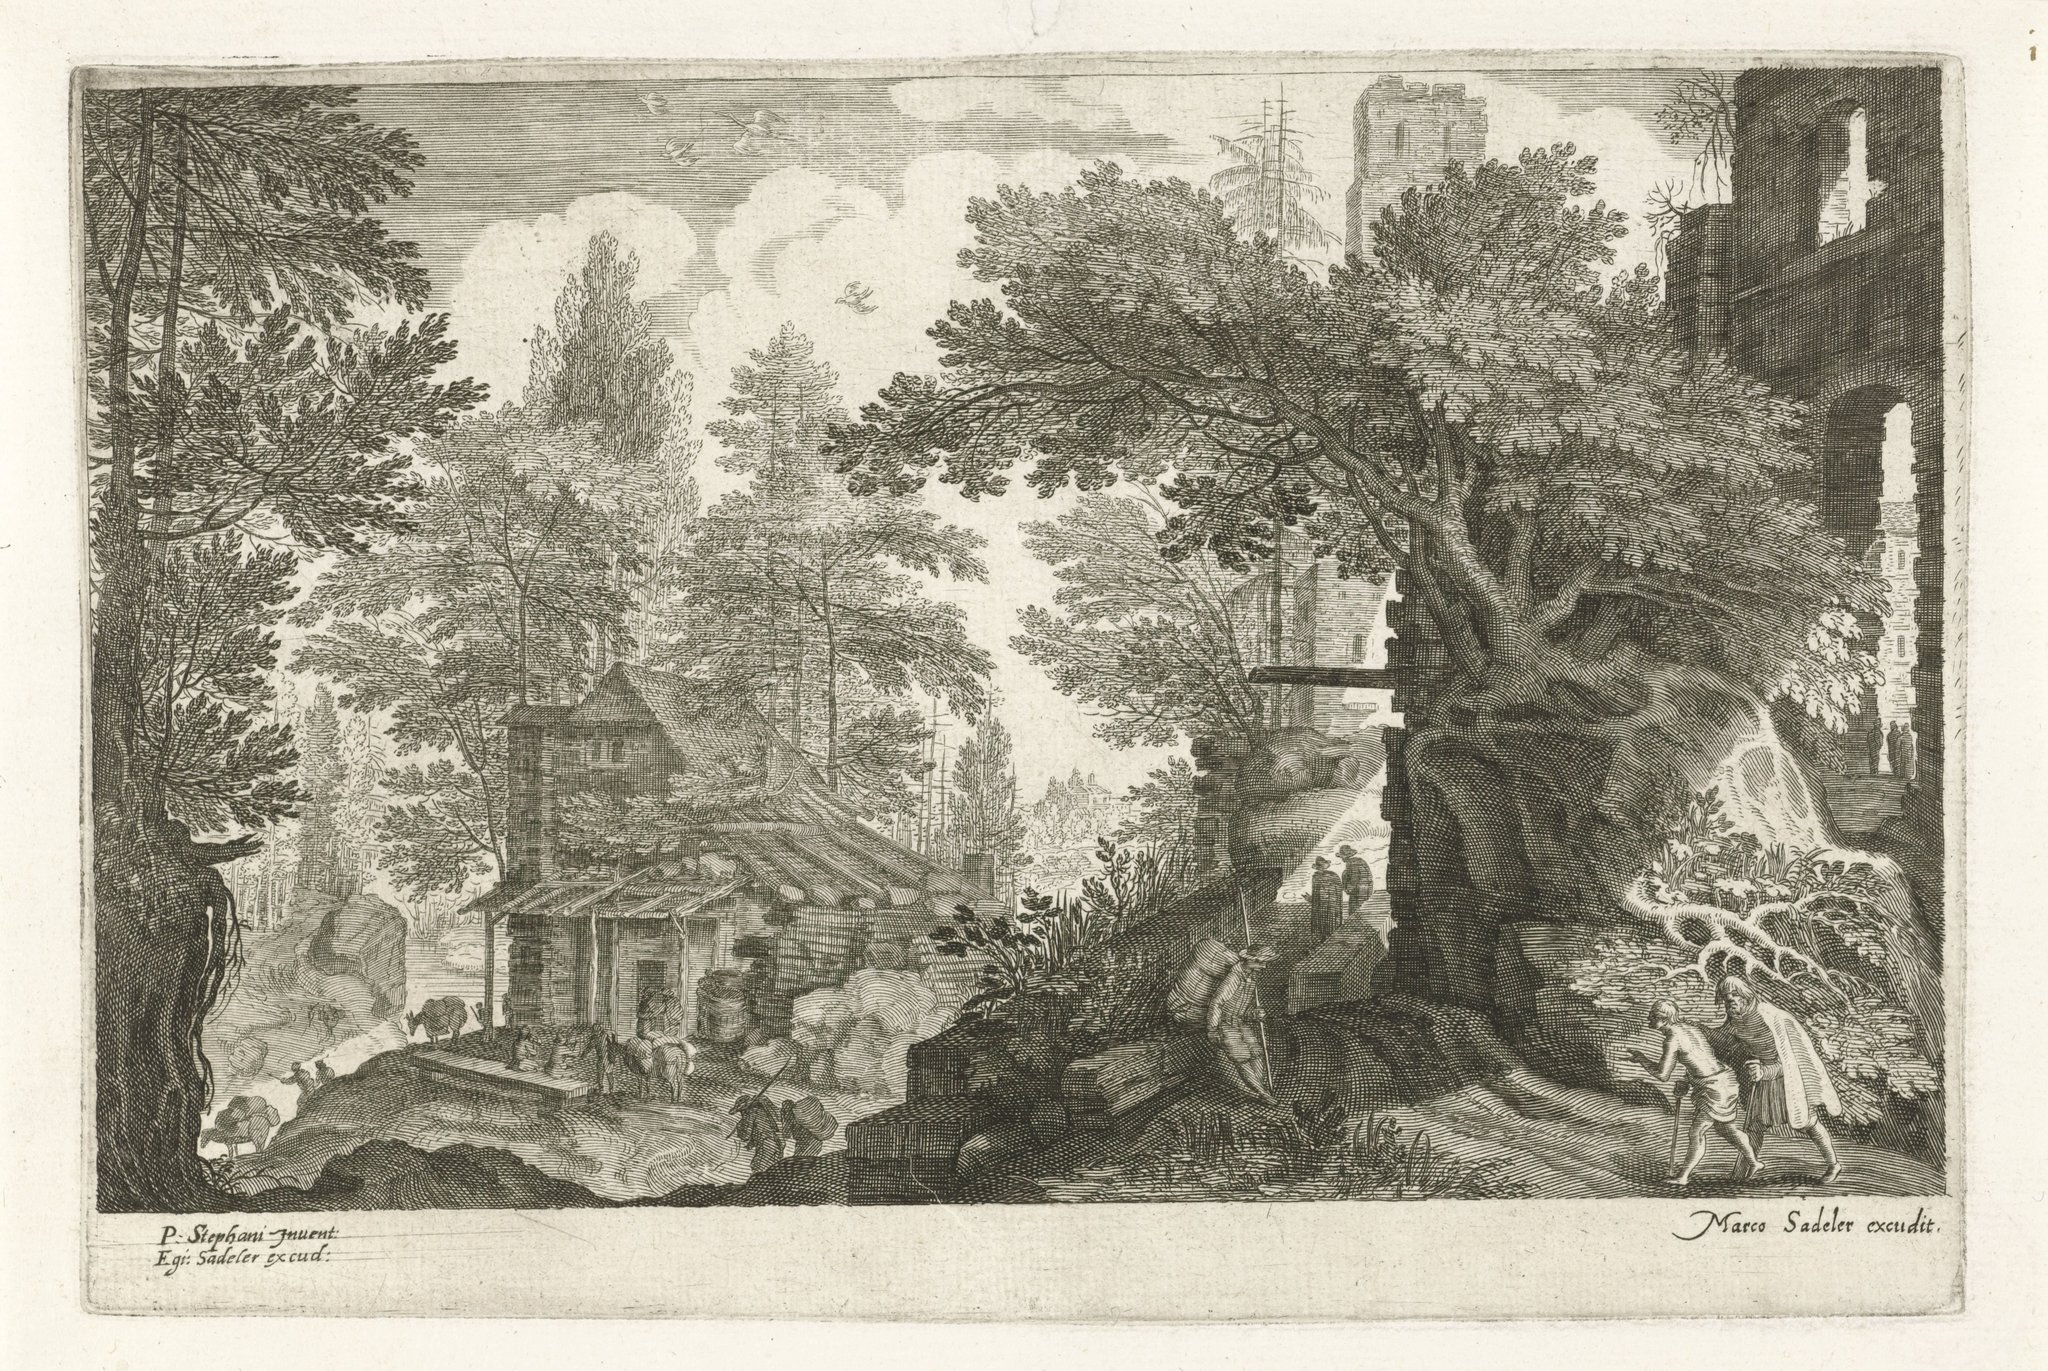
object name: print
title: Acht landschappen uit Bohemen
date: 1597-1629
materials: paper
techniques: engraving, etching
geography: venice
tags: inn, coffee-house, public house, etc., 'en route', traveller under way, forest, wood (+ landscape with figures, staffage)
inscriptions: collector's mark: Lugt 240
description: Een boslandschap. Op de weg reizigers. Op de achtergrond een herberg waar wandelaars rusten. De vierde prent van een achtdelige reeks met Boheemse landschappen.